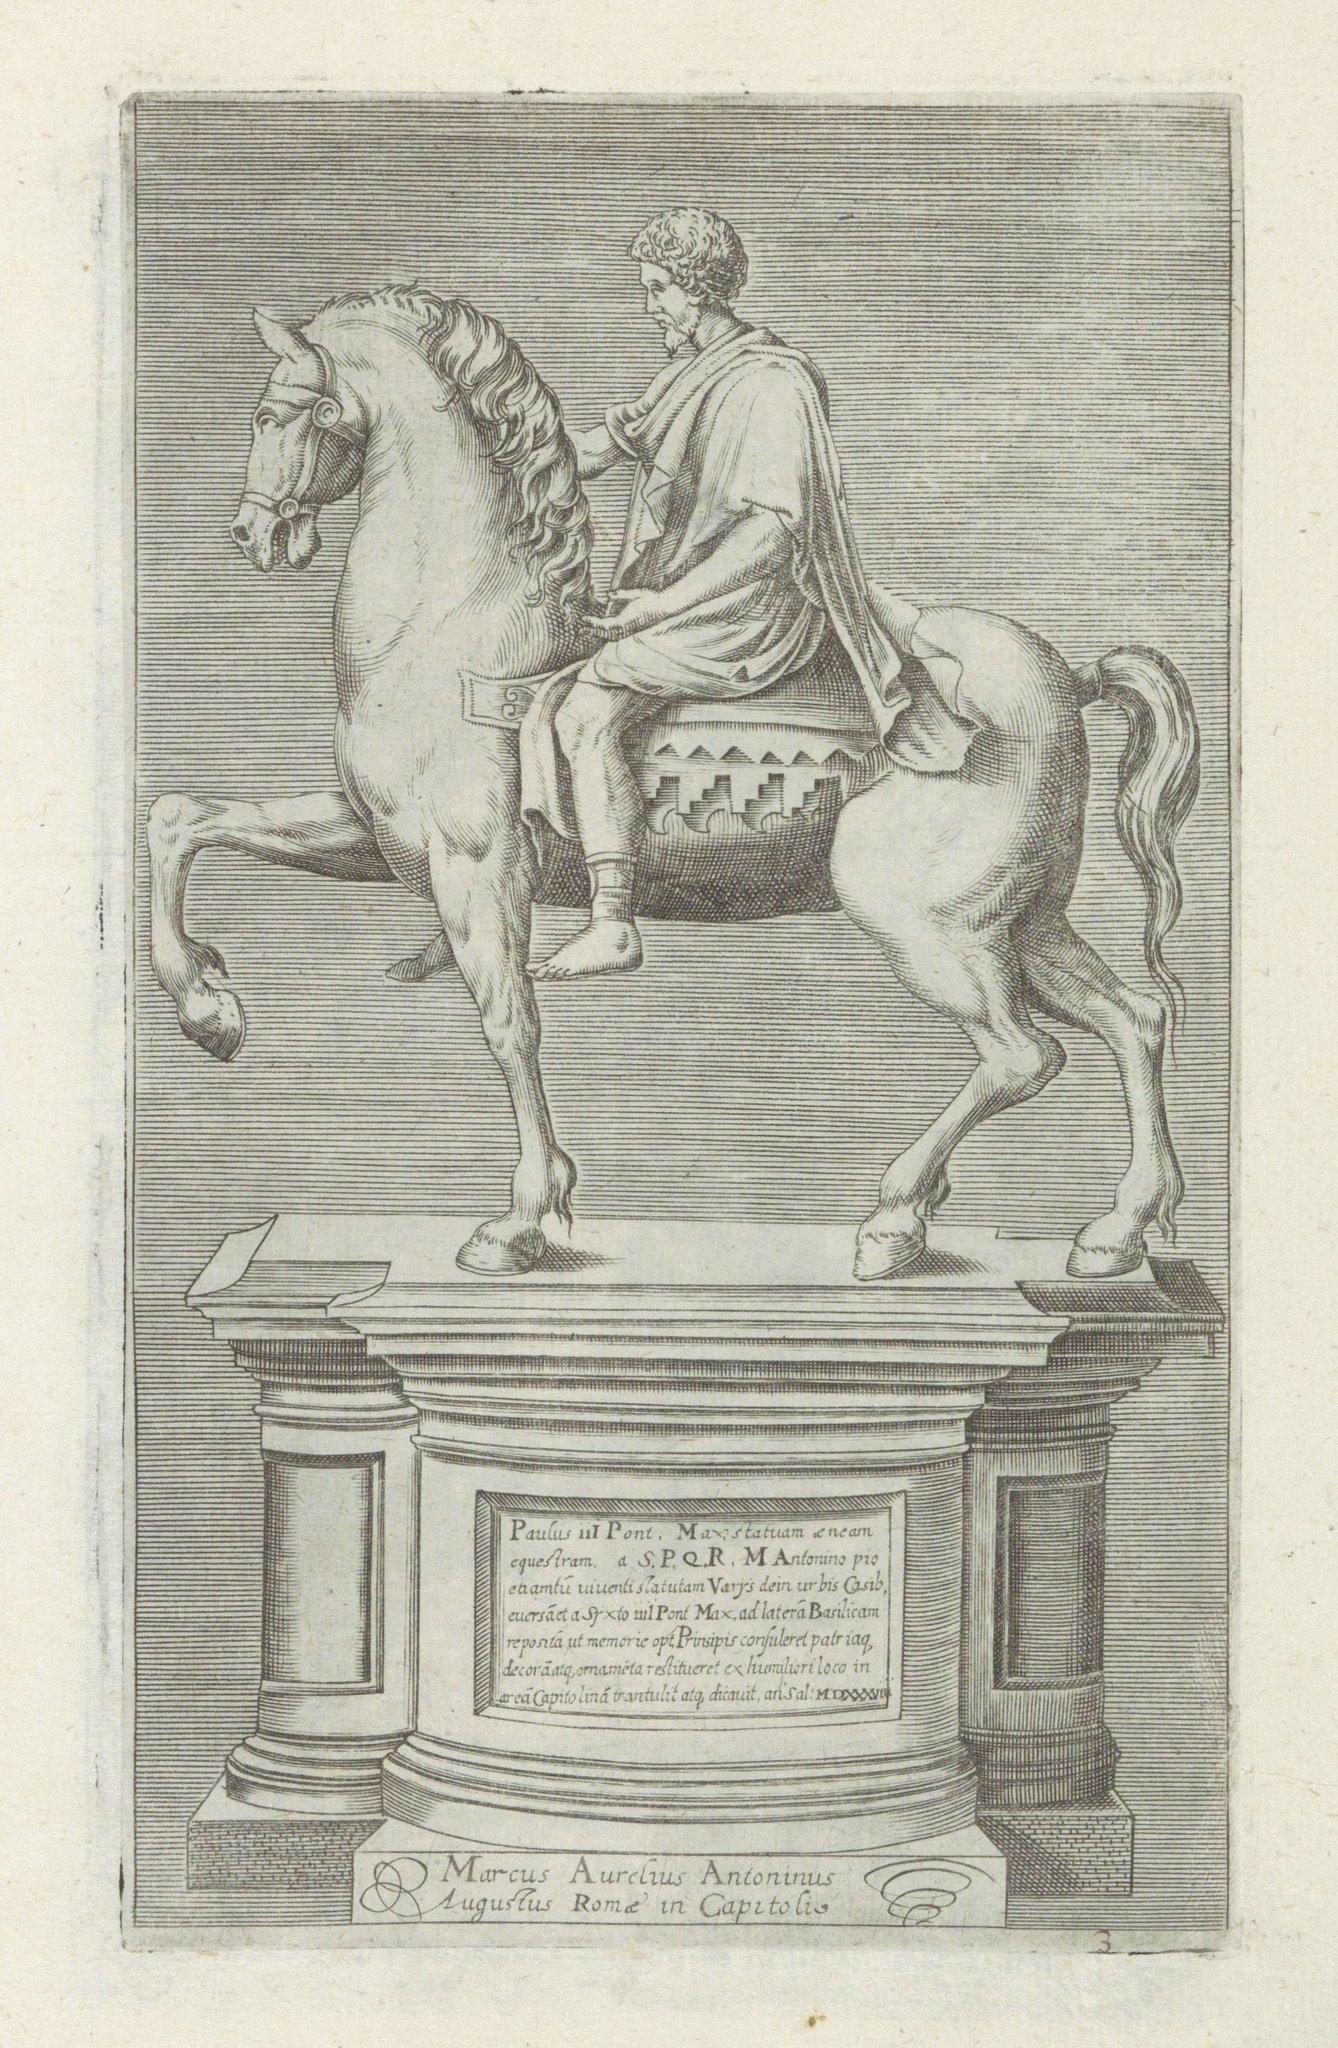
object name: album leaf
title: Antiquarum statuarum urbis Romae quae in publicis locis visuntur icones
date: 1584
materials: paper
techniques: engraving, intaglio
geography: italy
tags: rome, equestrian state-portrait, piece of sculpture, reproduction of a piece of sculpture, ruler, sovereign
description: Het ruiterstandbeeld van Marcus Aurelius op Piazza del Campidoglio in Rome. Onderschrift in het Latijn. Prent maakt deel uit van een album.